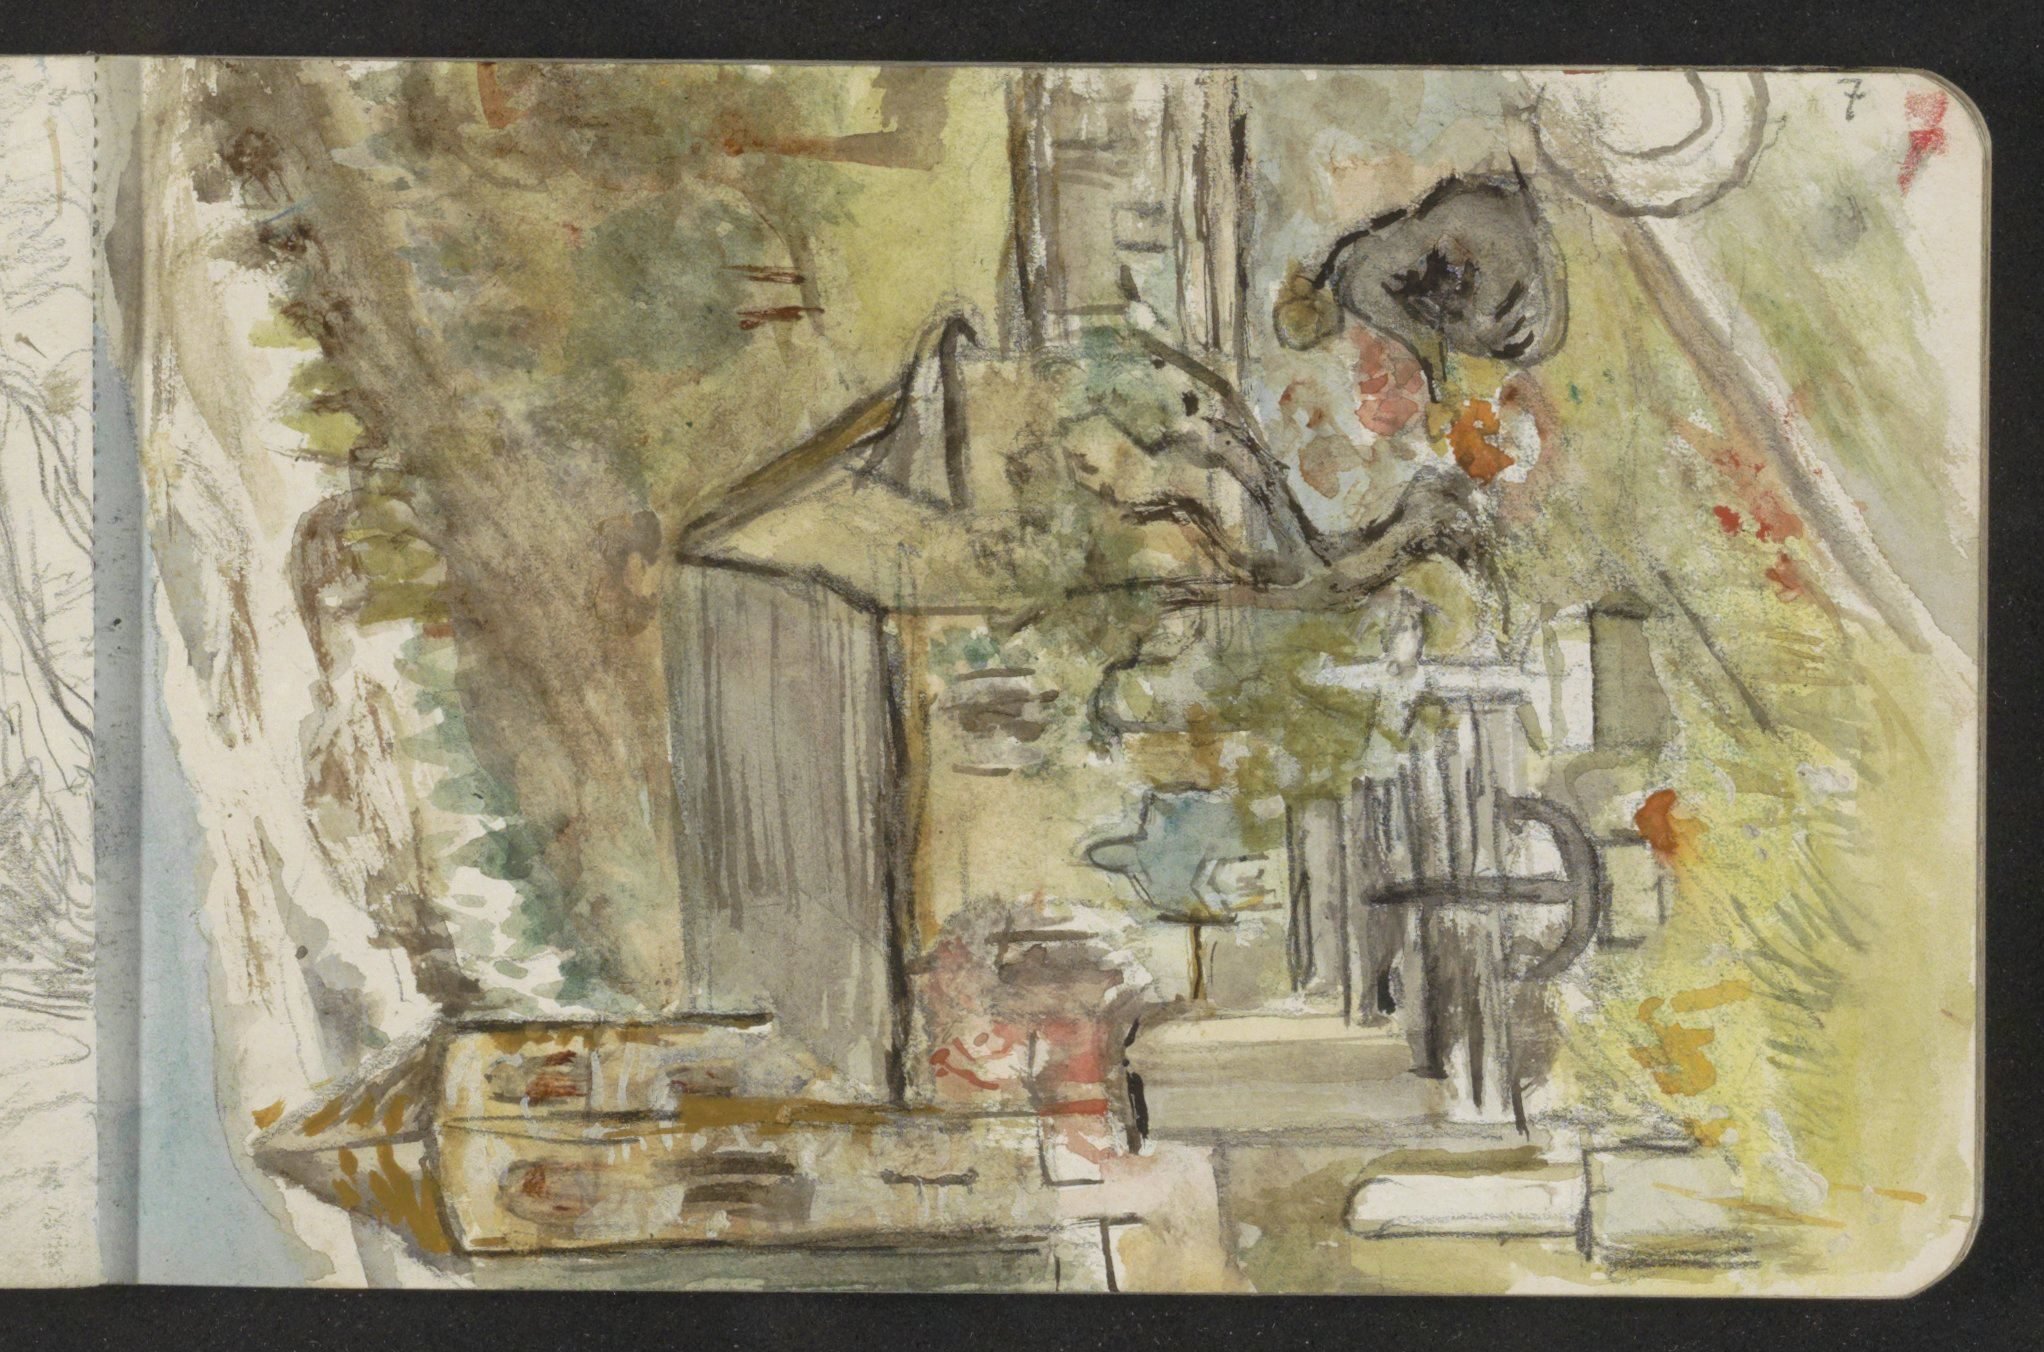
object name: sketchbook leaf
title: Hurkende vrouw op een begraafplaats in Pontresina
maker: jozef israëls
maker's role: draughtsman, painter, print maker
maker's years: 1824-1911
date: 1869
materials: paper, pencil, watercolor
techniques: brush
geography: pontresina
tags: churchyard, cemetery, squatting, crouching figure - aa - female human figure, mountains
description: Op de achtergrond bergen en een kerktoren. Blad 7 recto uit een schetsboek met 36 bladen.